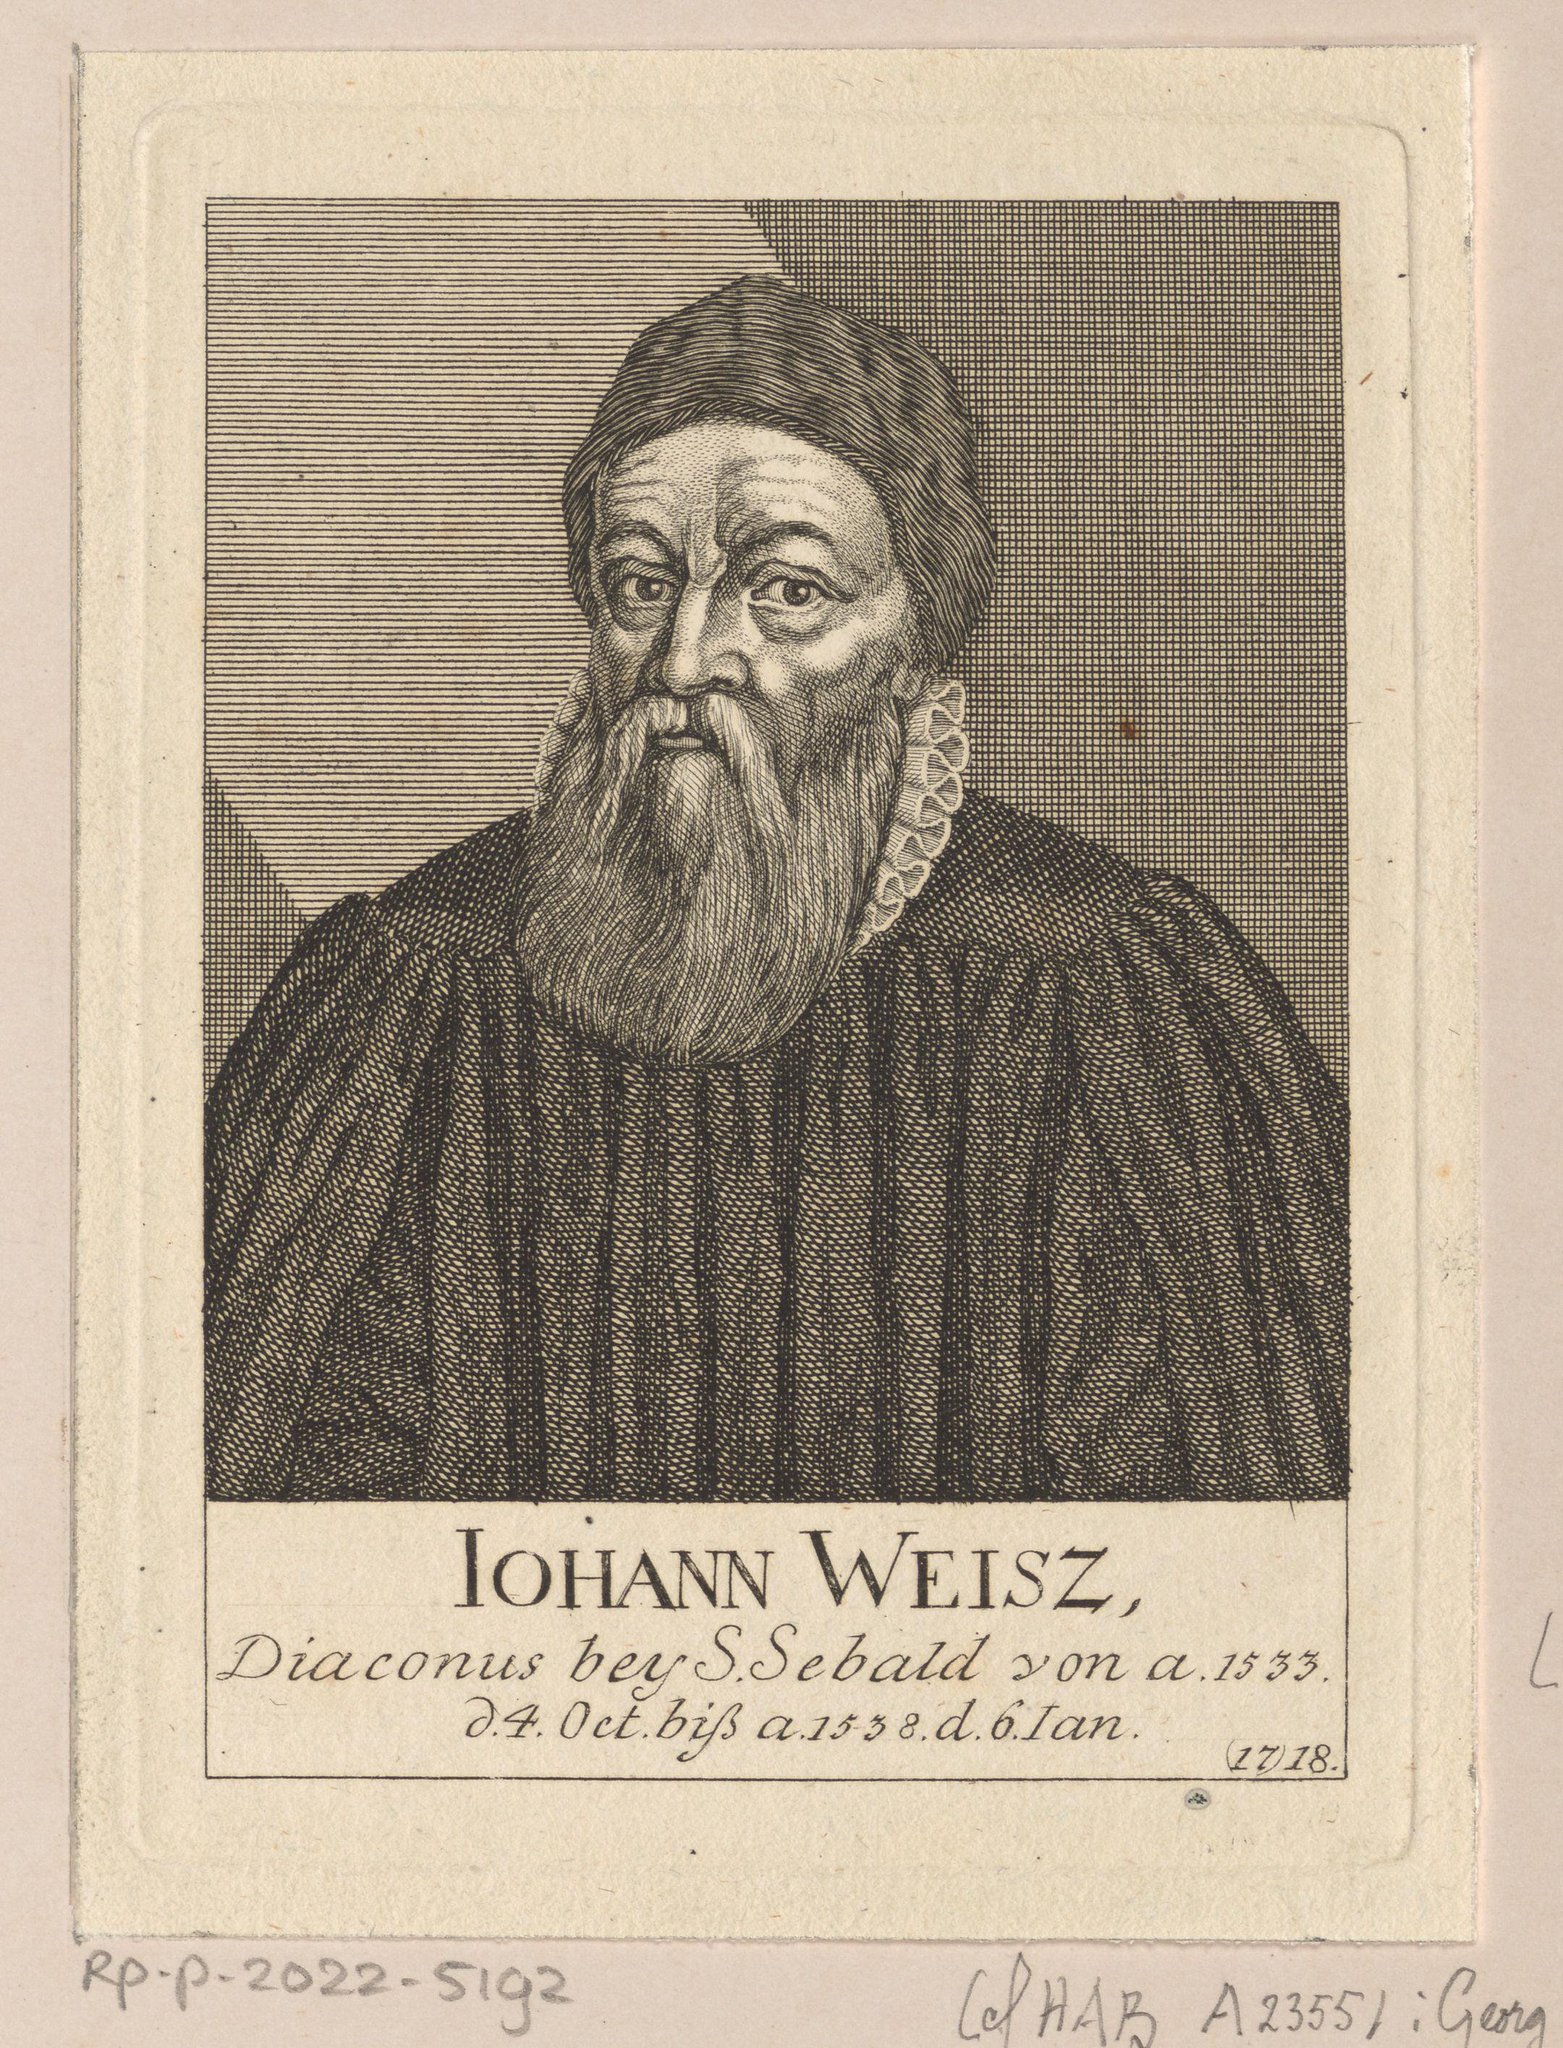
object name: print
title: Portret van Johann Weiß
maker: Anonymous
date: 1756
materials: paper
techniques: engraving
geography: germany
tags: historical persons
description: Prent waarschijnlijk uit: Würfel, Andreas. Diptycha ecclesiae Sebaldianae (...). Neurenberg: Christoph Melchior Roth, 1756.